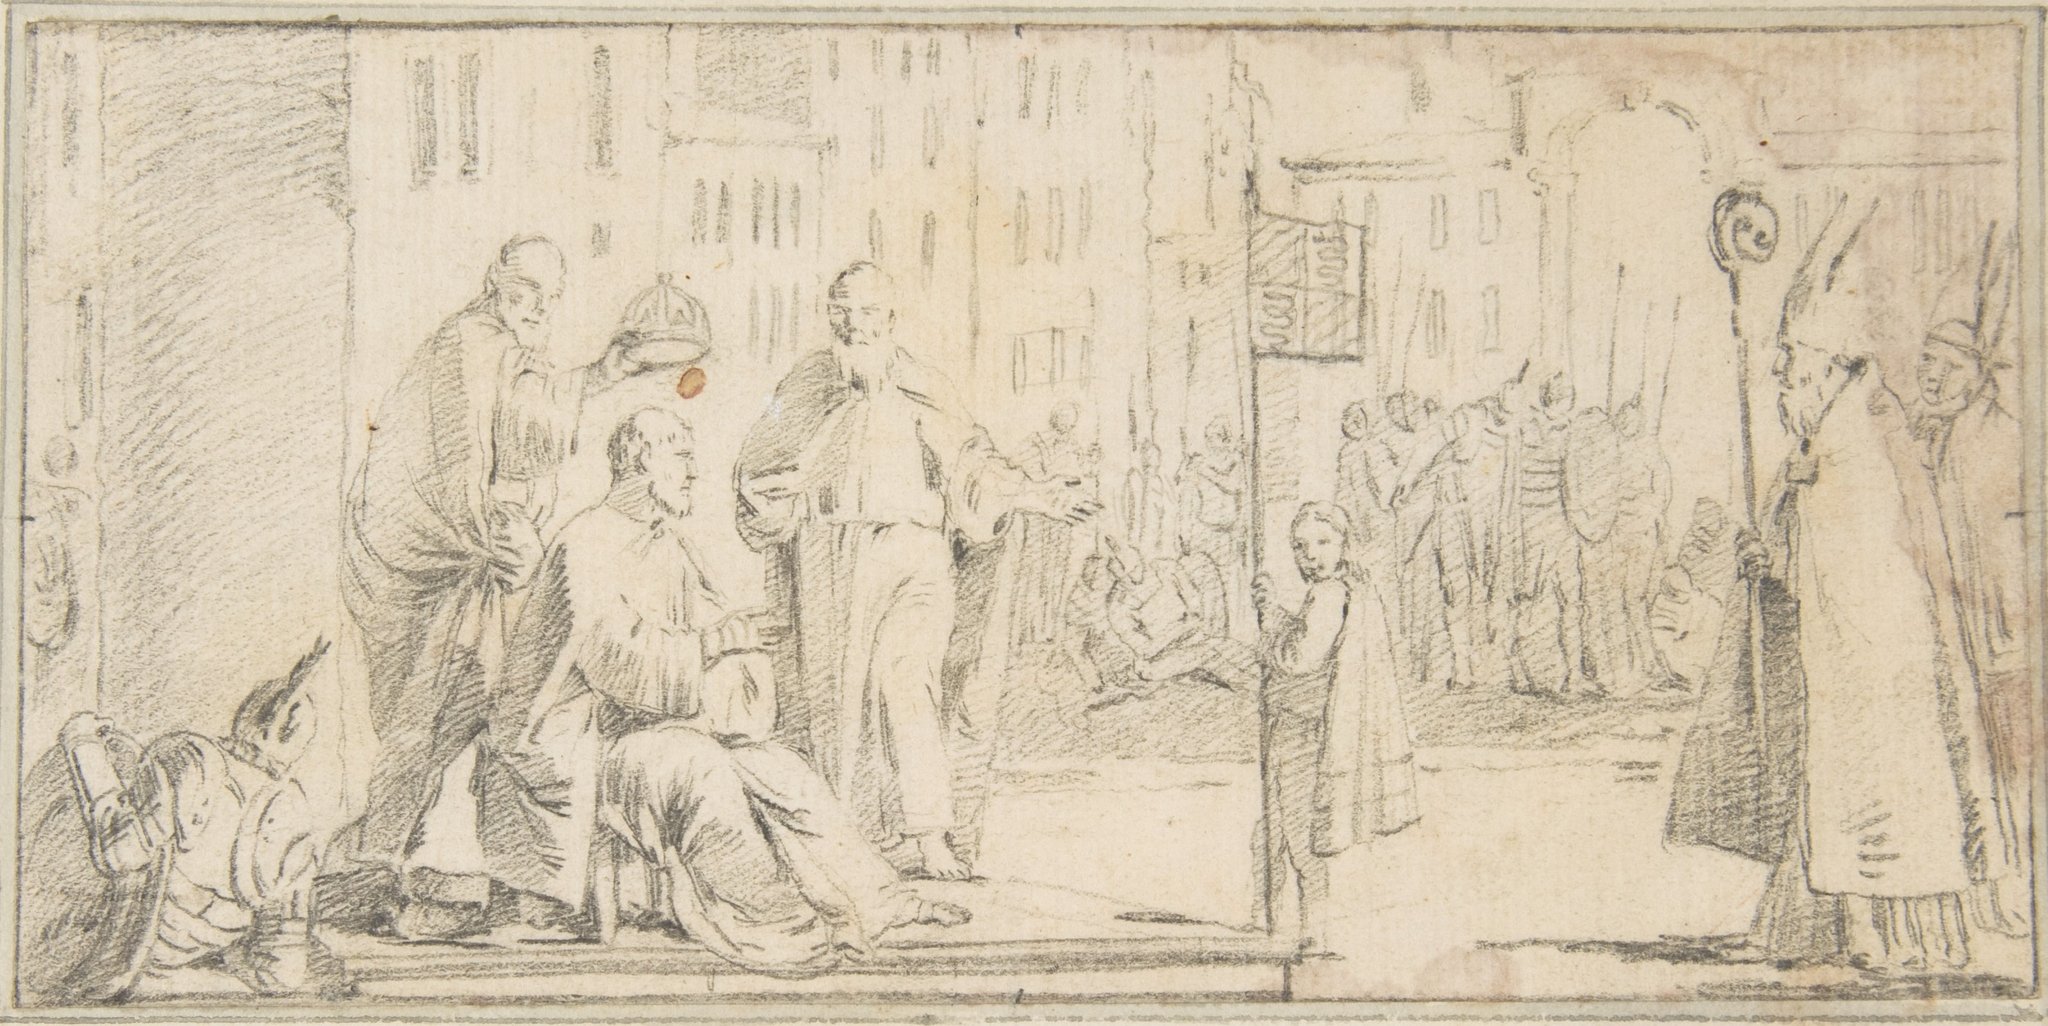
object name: drawing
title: Illustration for a Book: Coronation of an Emperor (?)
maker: giovanni battista tiepolo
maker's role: artist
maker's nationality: italian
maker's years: 1696-1770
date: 1696-1770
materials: chalk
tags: ceremony,crowd